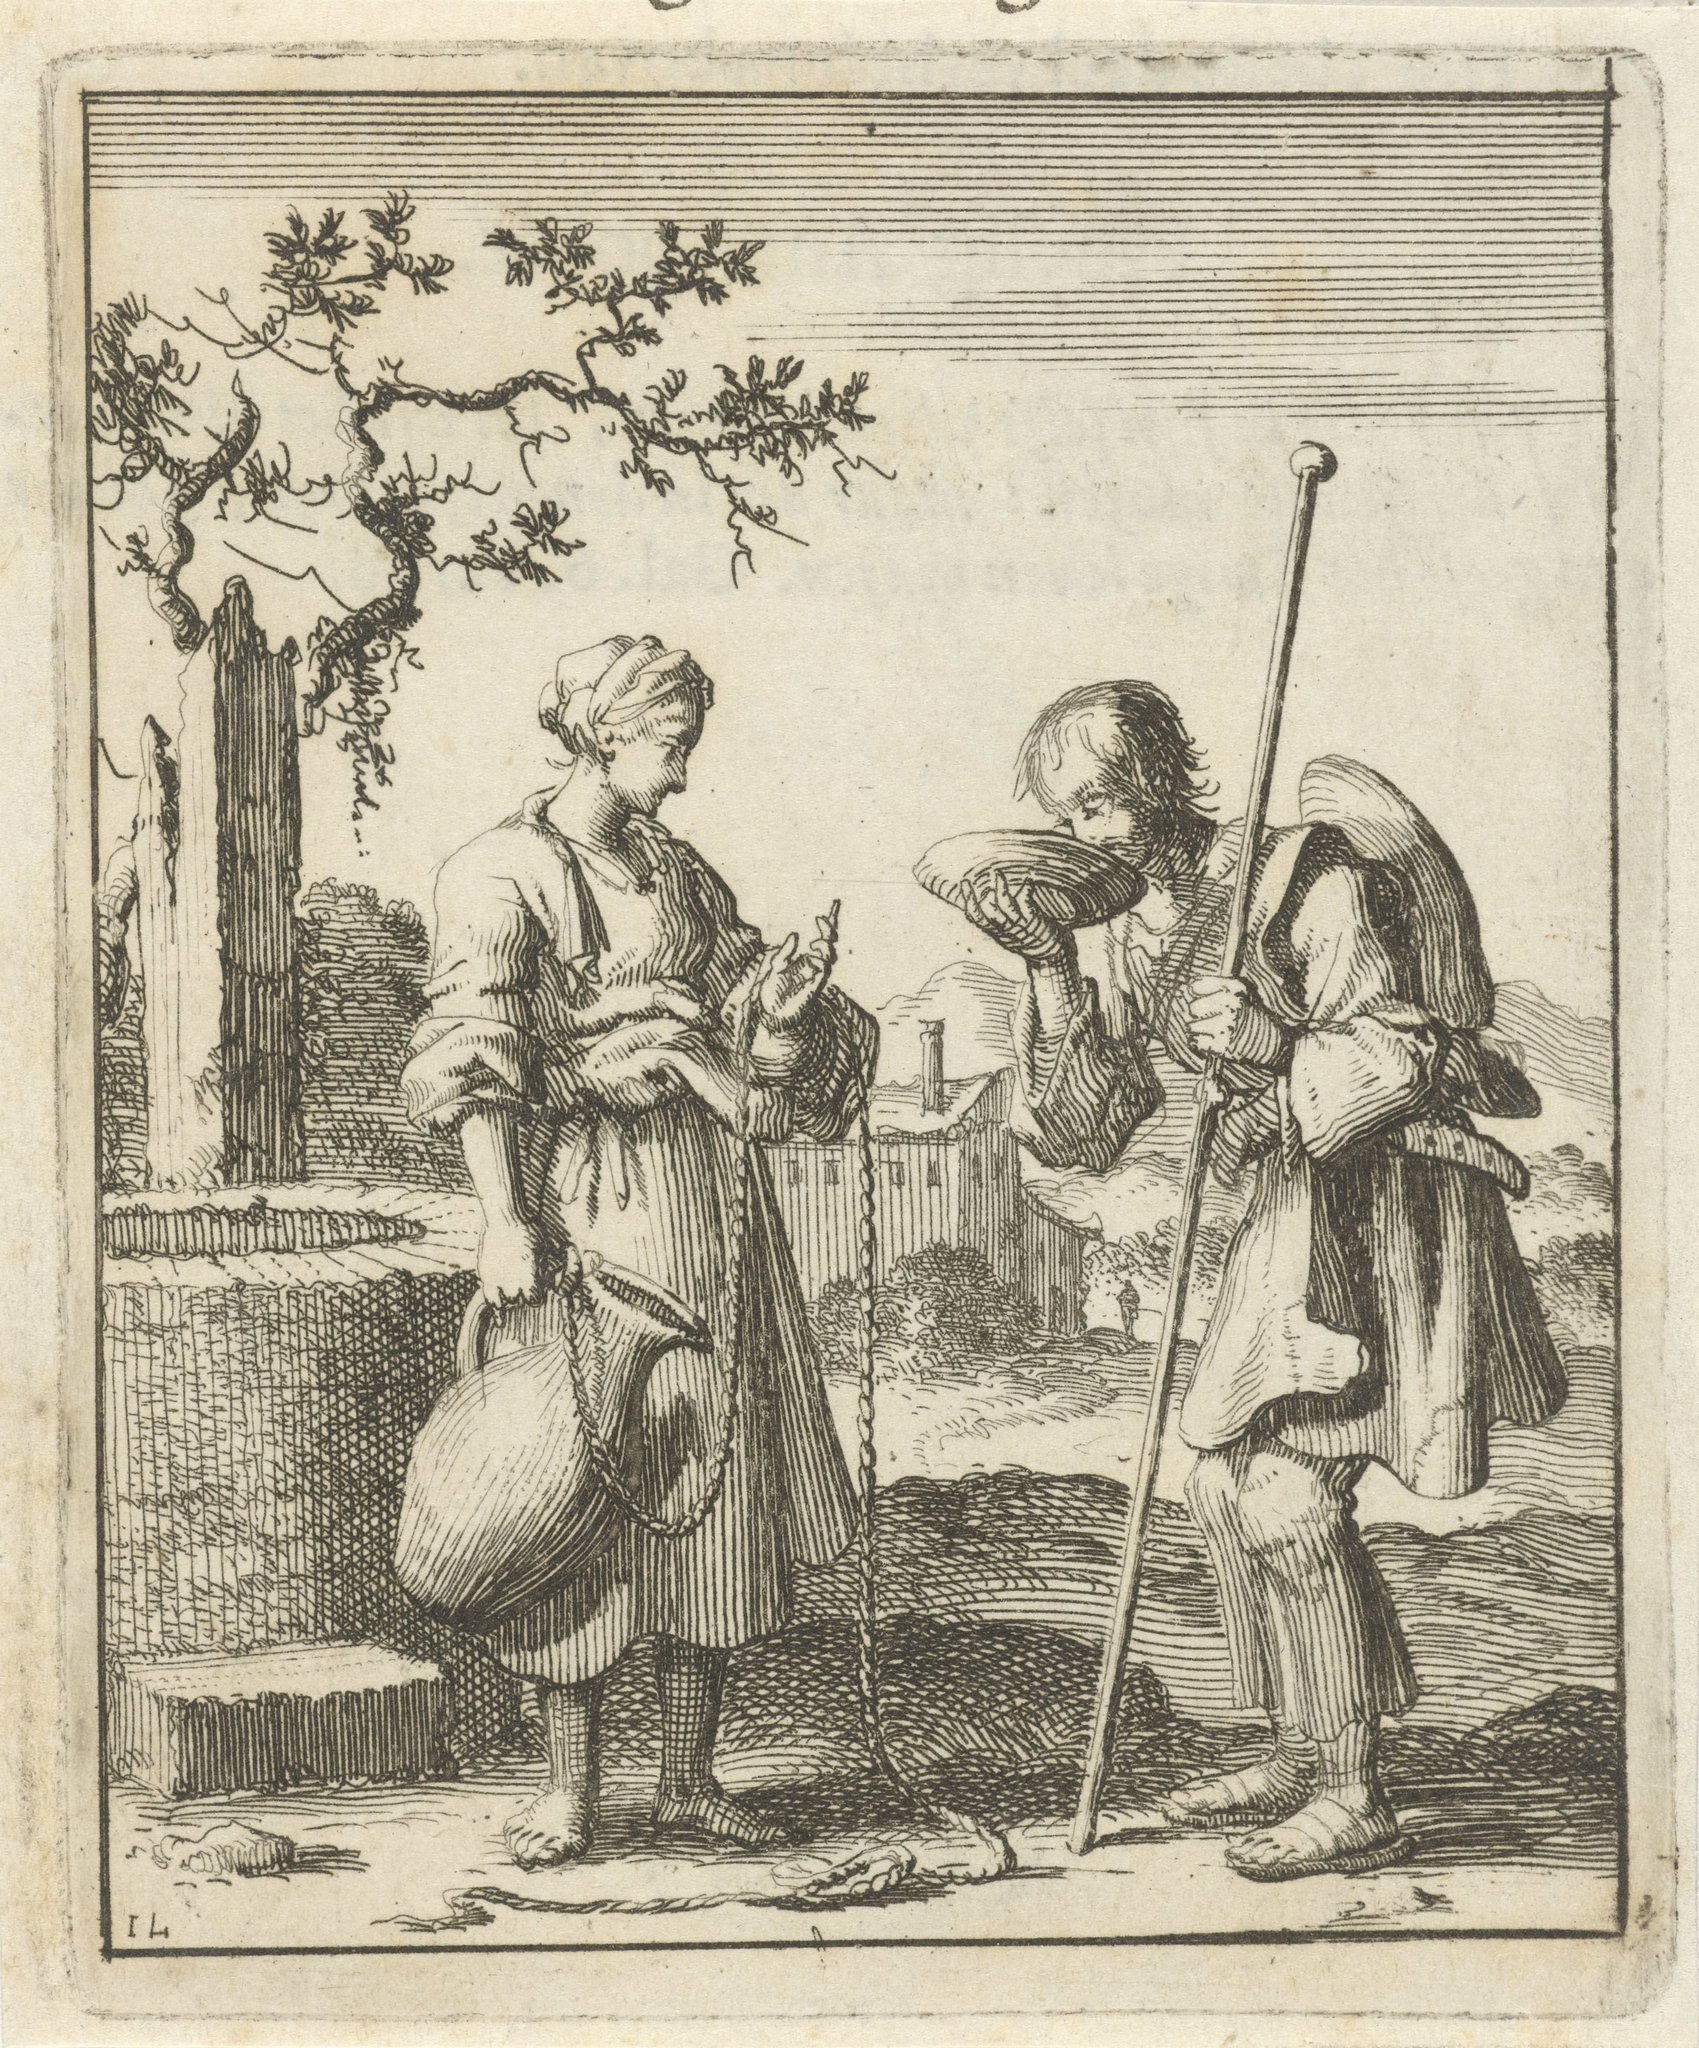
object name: book illustration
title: Vrouw geeft een pelgrim water uit een kruik te drinken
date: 1687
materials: paper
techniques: etching, letterpress printing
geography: amsterdam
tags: pilgrim(s), giving drink, container of ceramics: jar, jug, pot, vase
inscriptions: collector's mark: Lugt 2228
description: Illustratie uit: Luyken, Jan. Voncken der liefde Jesu, van het godtbegerende zielenvier. Amsterdam: Pieter Arentsz (II), 1687, p. 30.